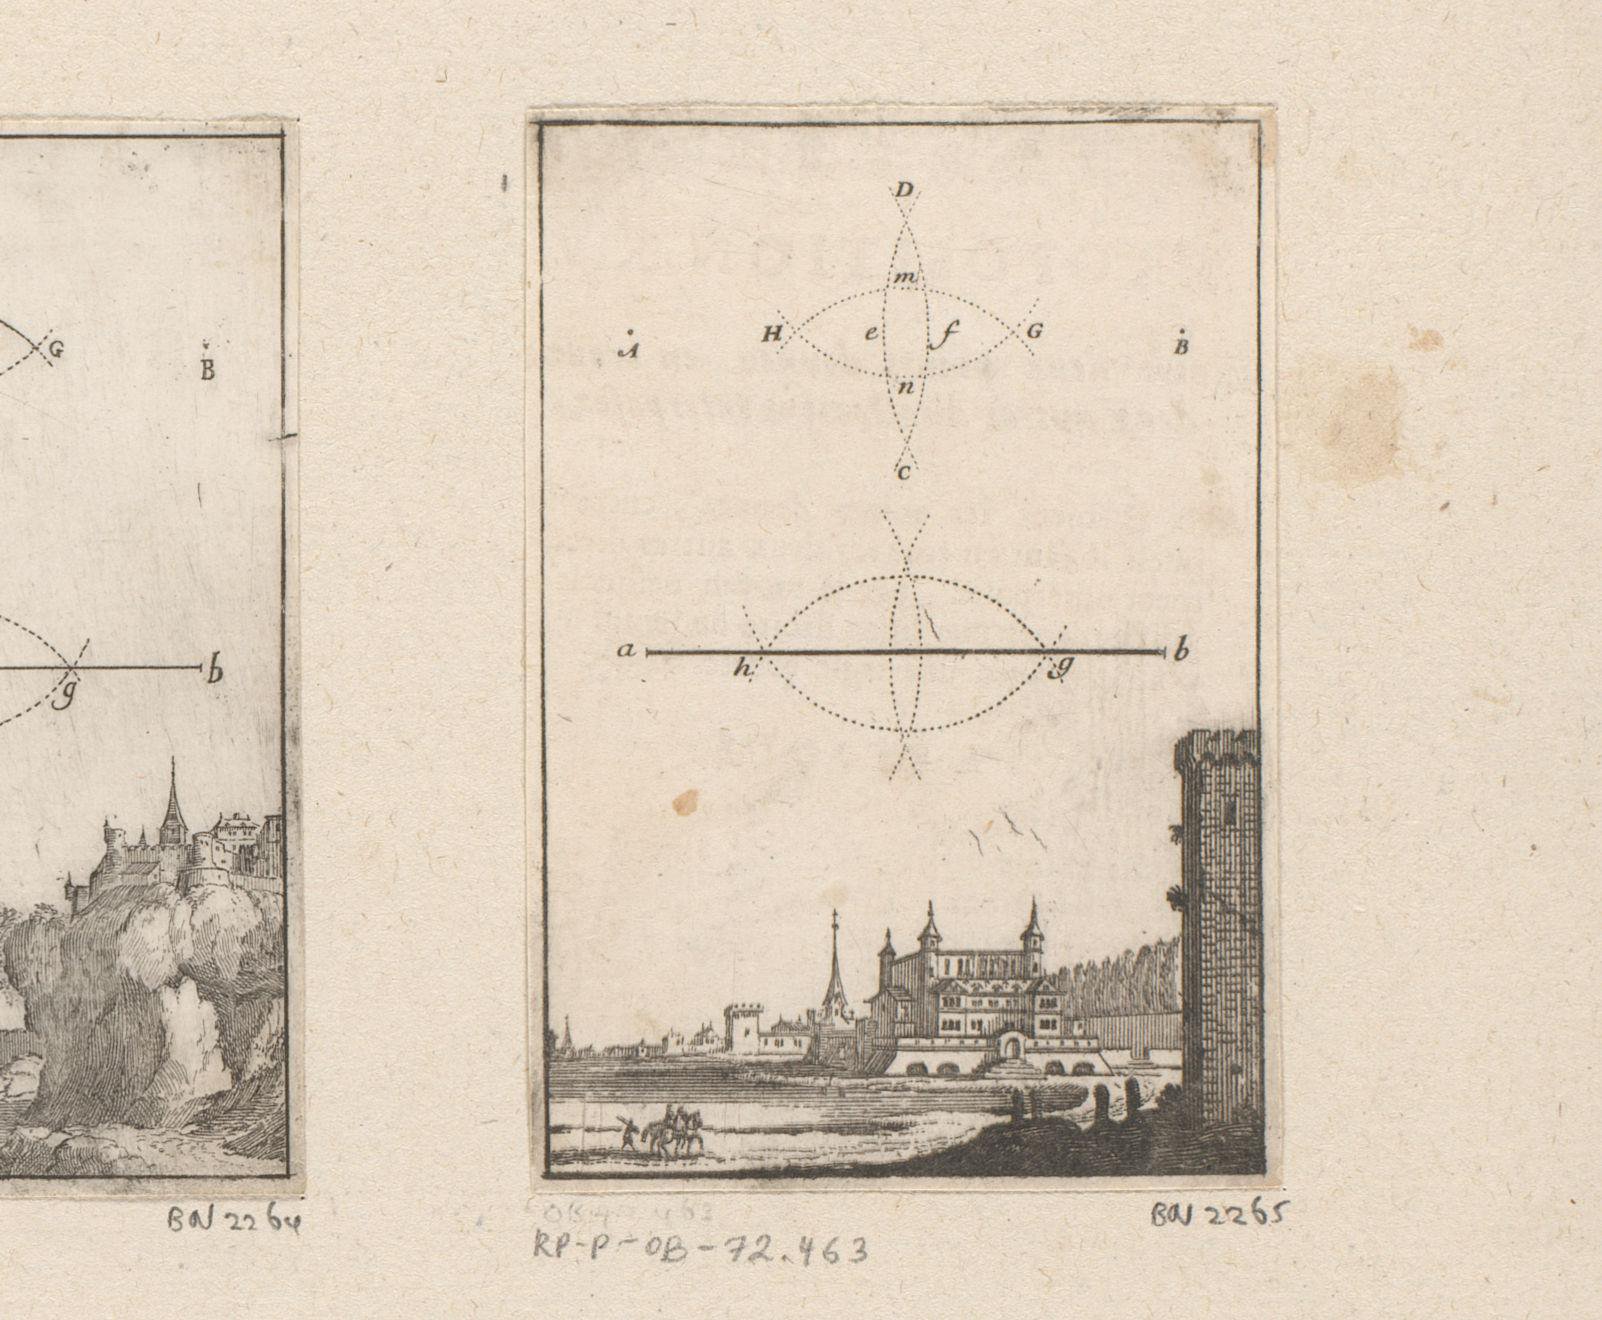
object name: book illustration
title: Verhouding tussen twee gegeven punten met onderaan zicht op een stad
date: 1669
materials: paper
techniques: etching, letterpress printing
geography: france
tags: city-view, and landscape with man-made constructions, planimetry, geometry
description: Prent uit: Pratique de la géometrie, sur le papier et sur le terrain. Avec un nouvel ordre et une méthode particulière. Parijs: Thomas Jolly, 1669.